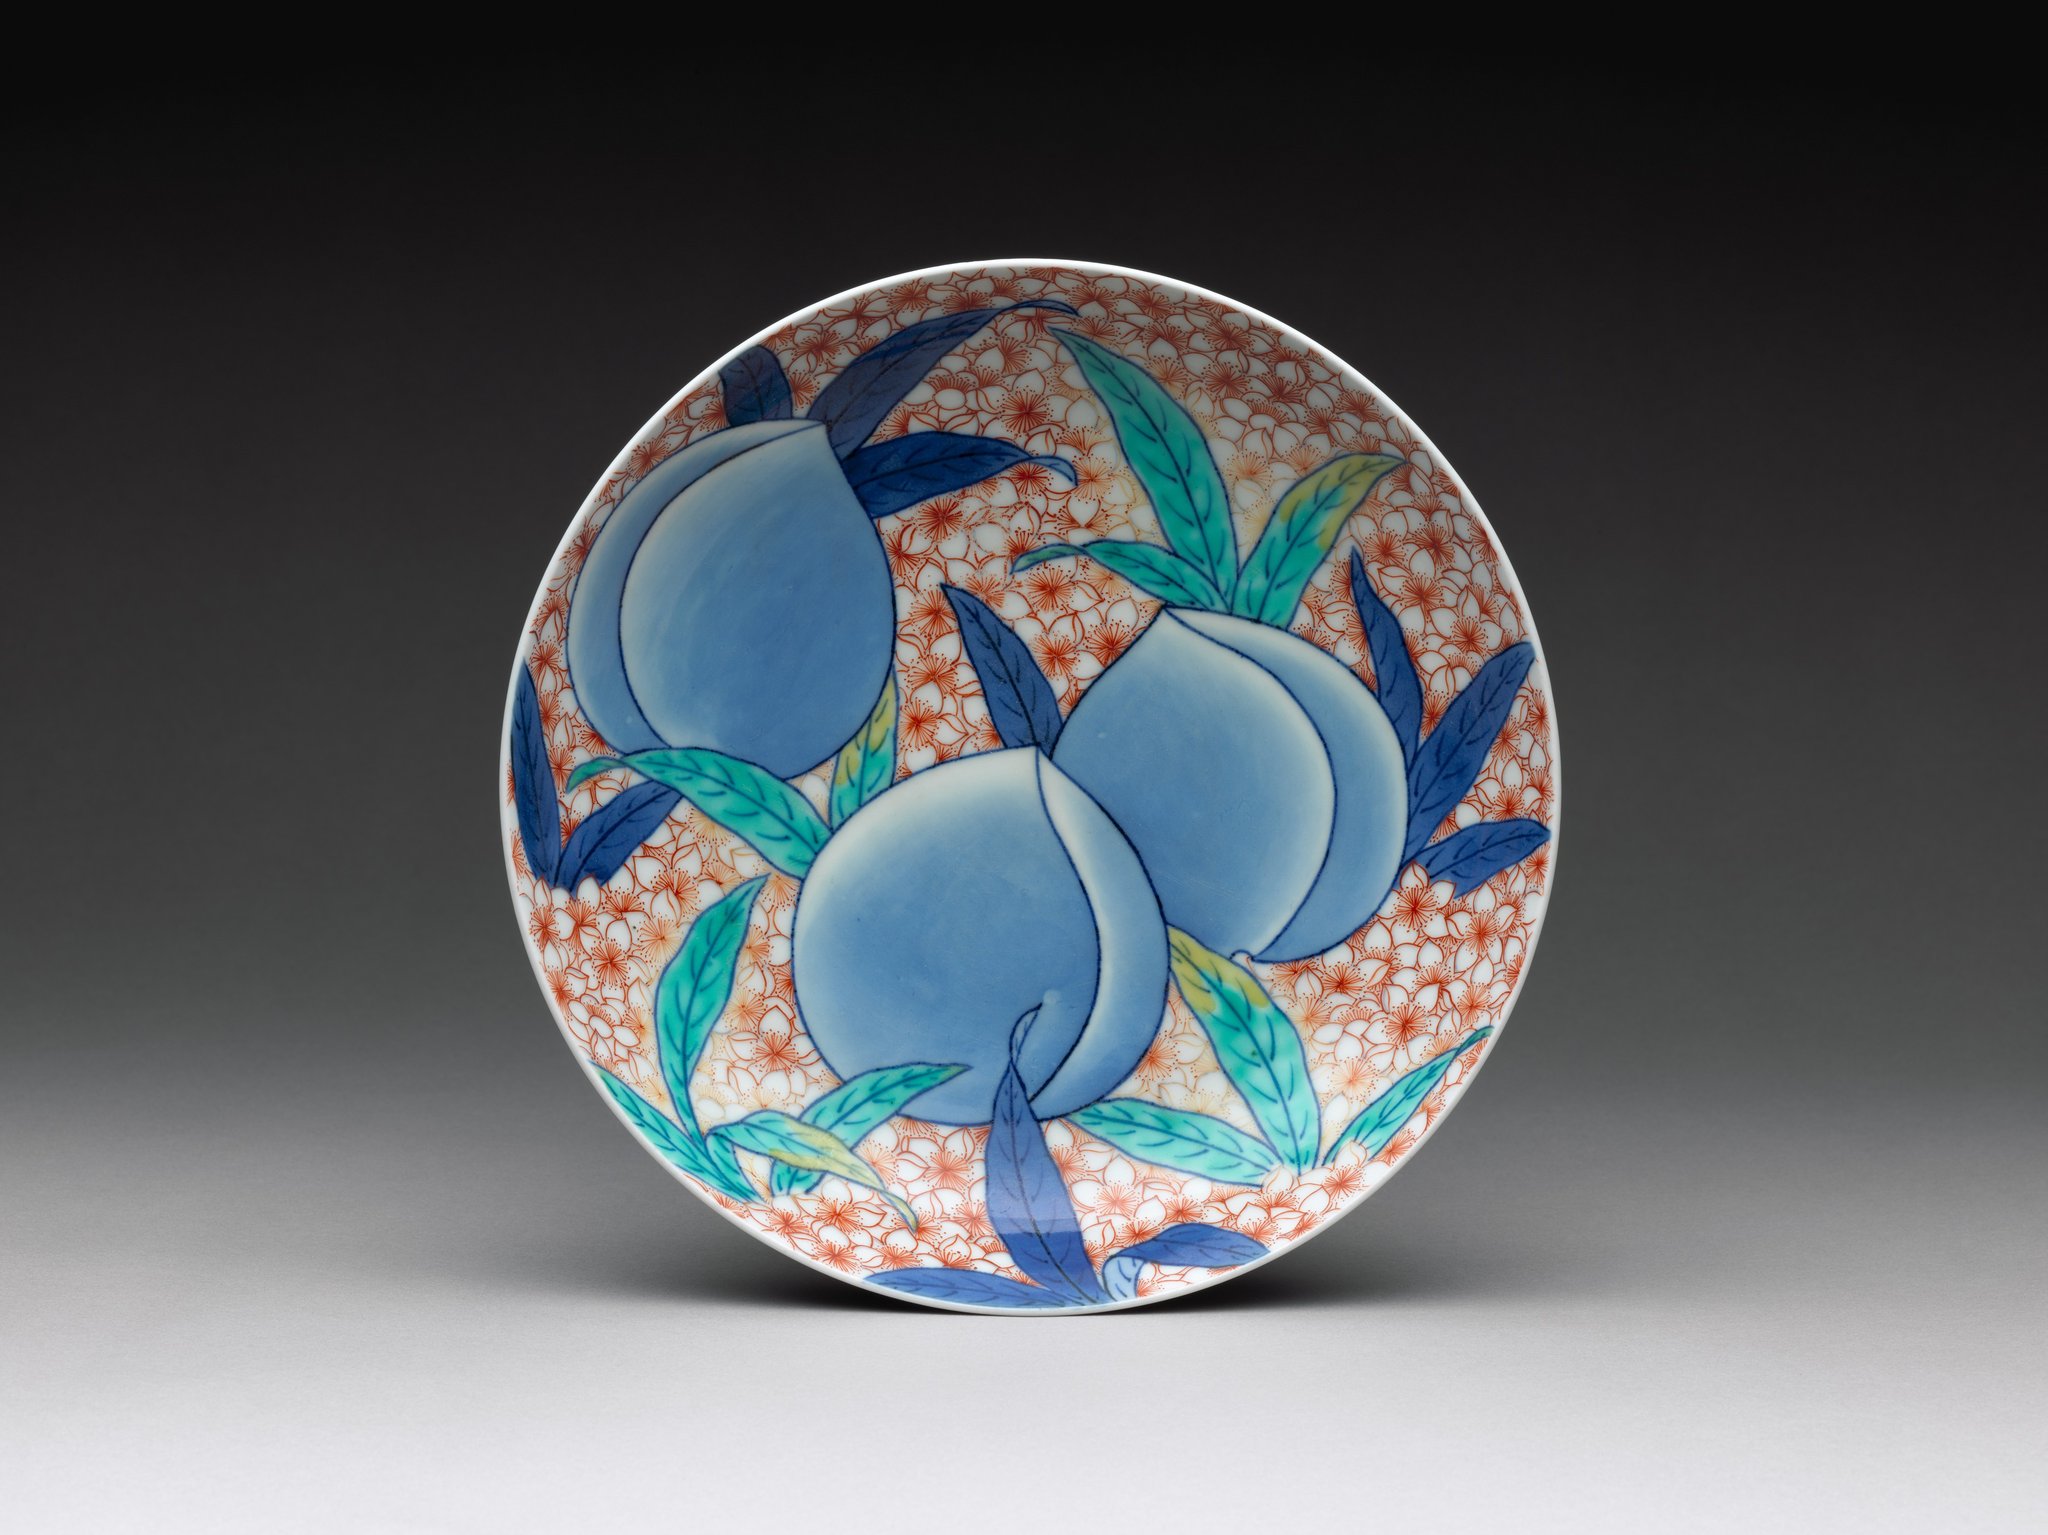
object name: dish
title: Dish with Peaches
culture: japanese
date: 1690-1720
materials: enamel, porcelain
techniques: overglaze, polychrome, underglaze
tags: peaches